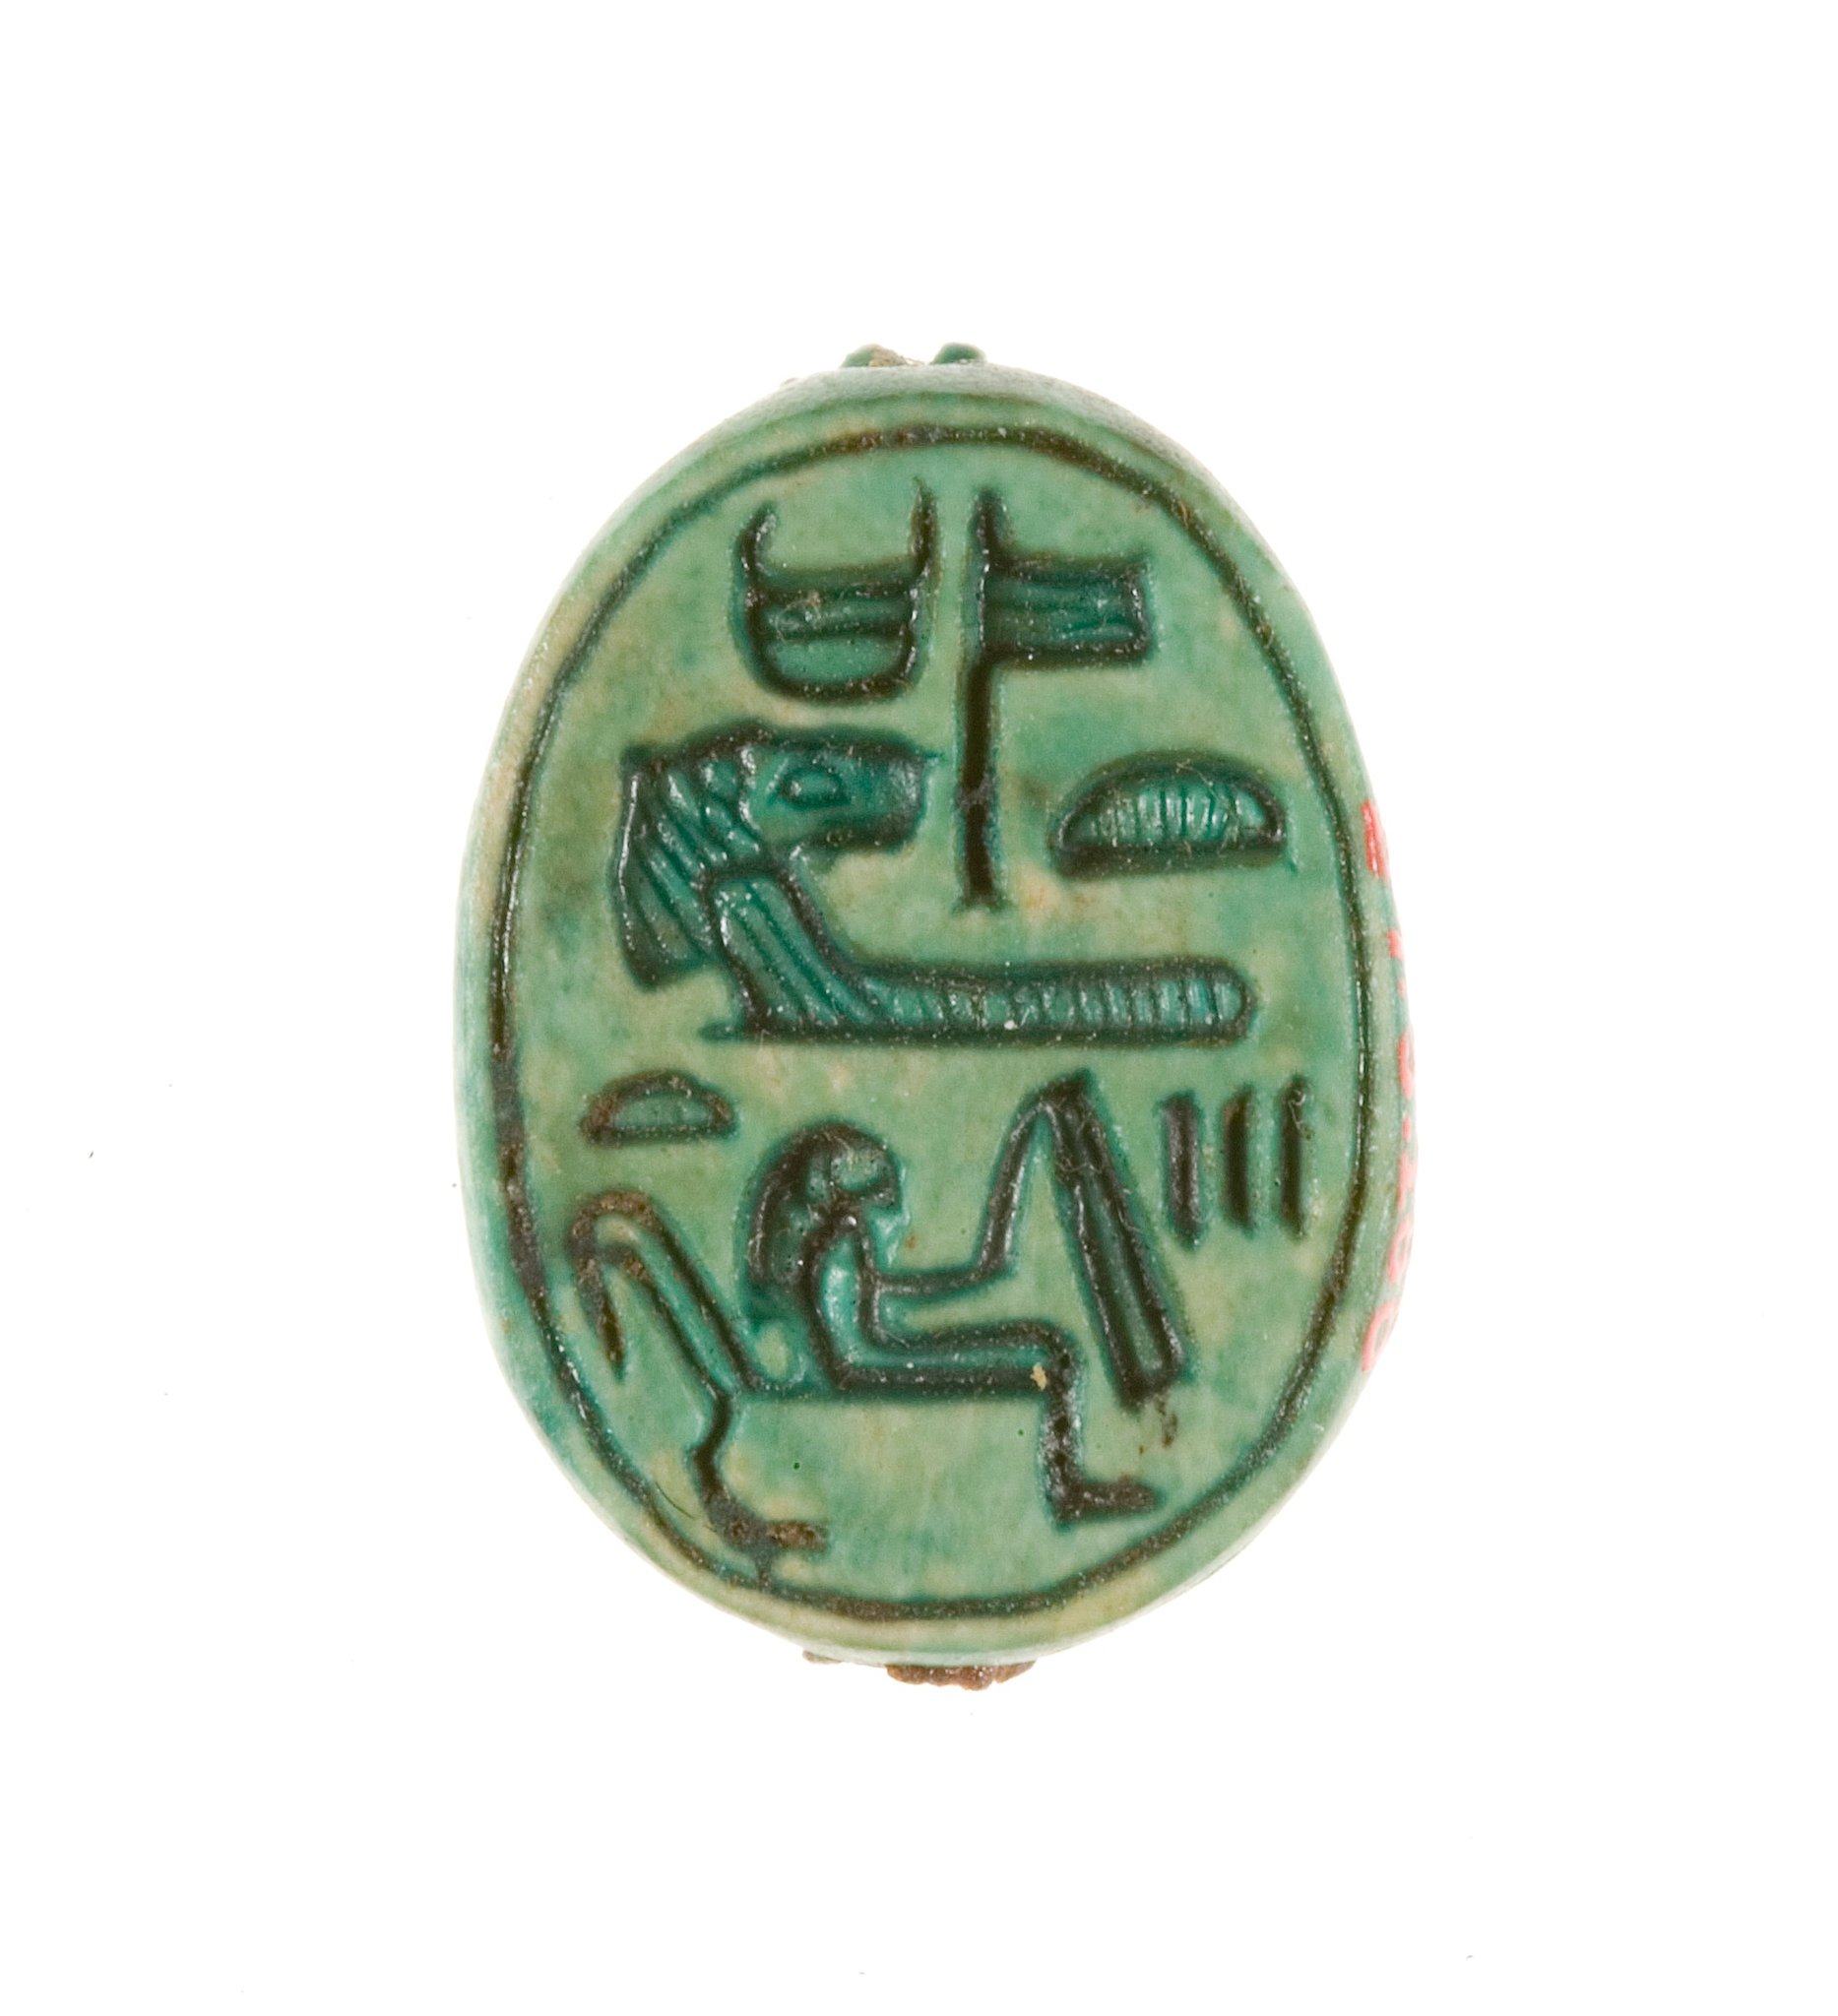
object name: scarab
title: Scarab Inscribed for the God's Wife Hatshepsut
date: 1479-1458 BCE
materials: stone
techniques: glazing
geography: egypt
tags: hieroglyphs,scarabs